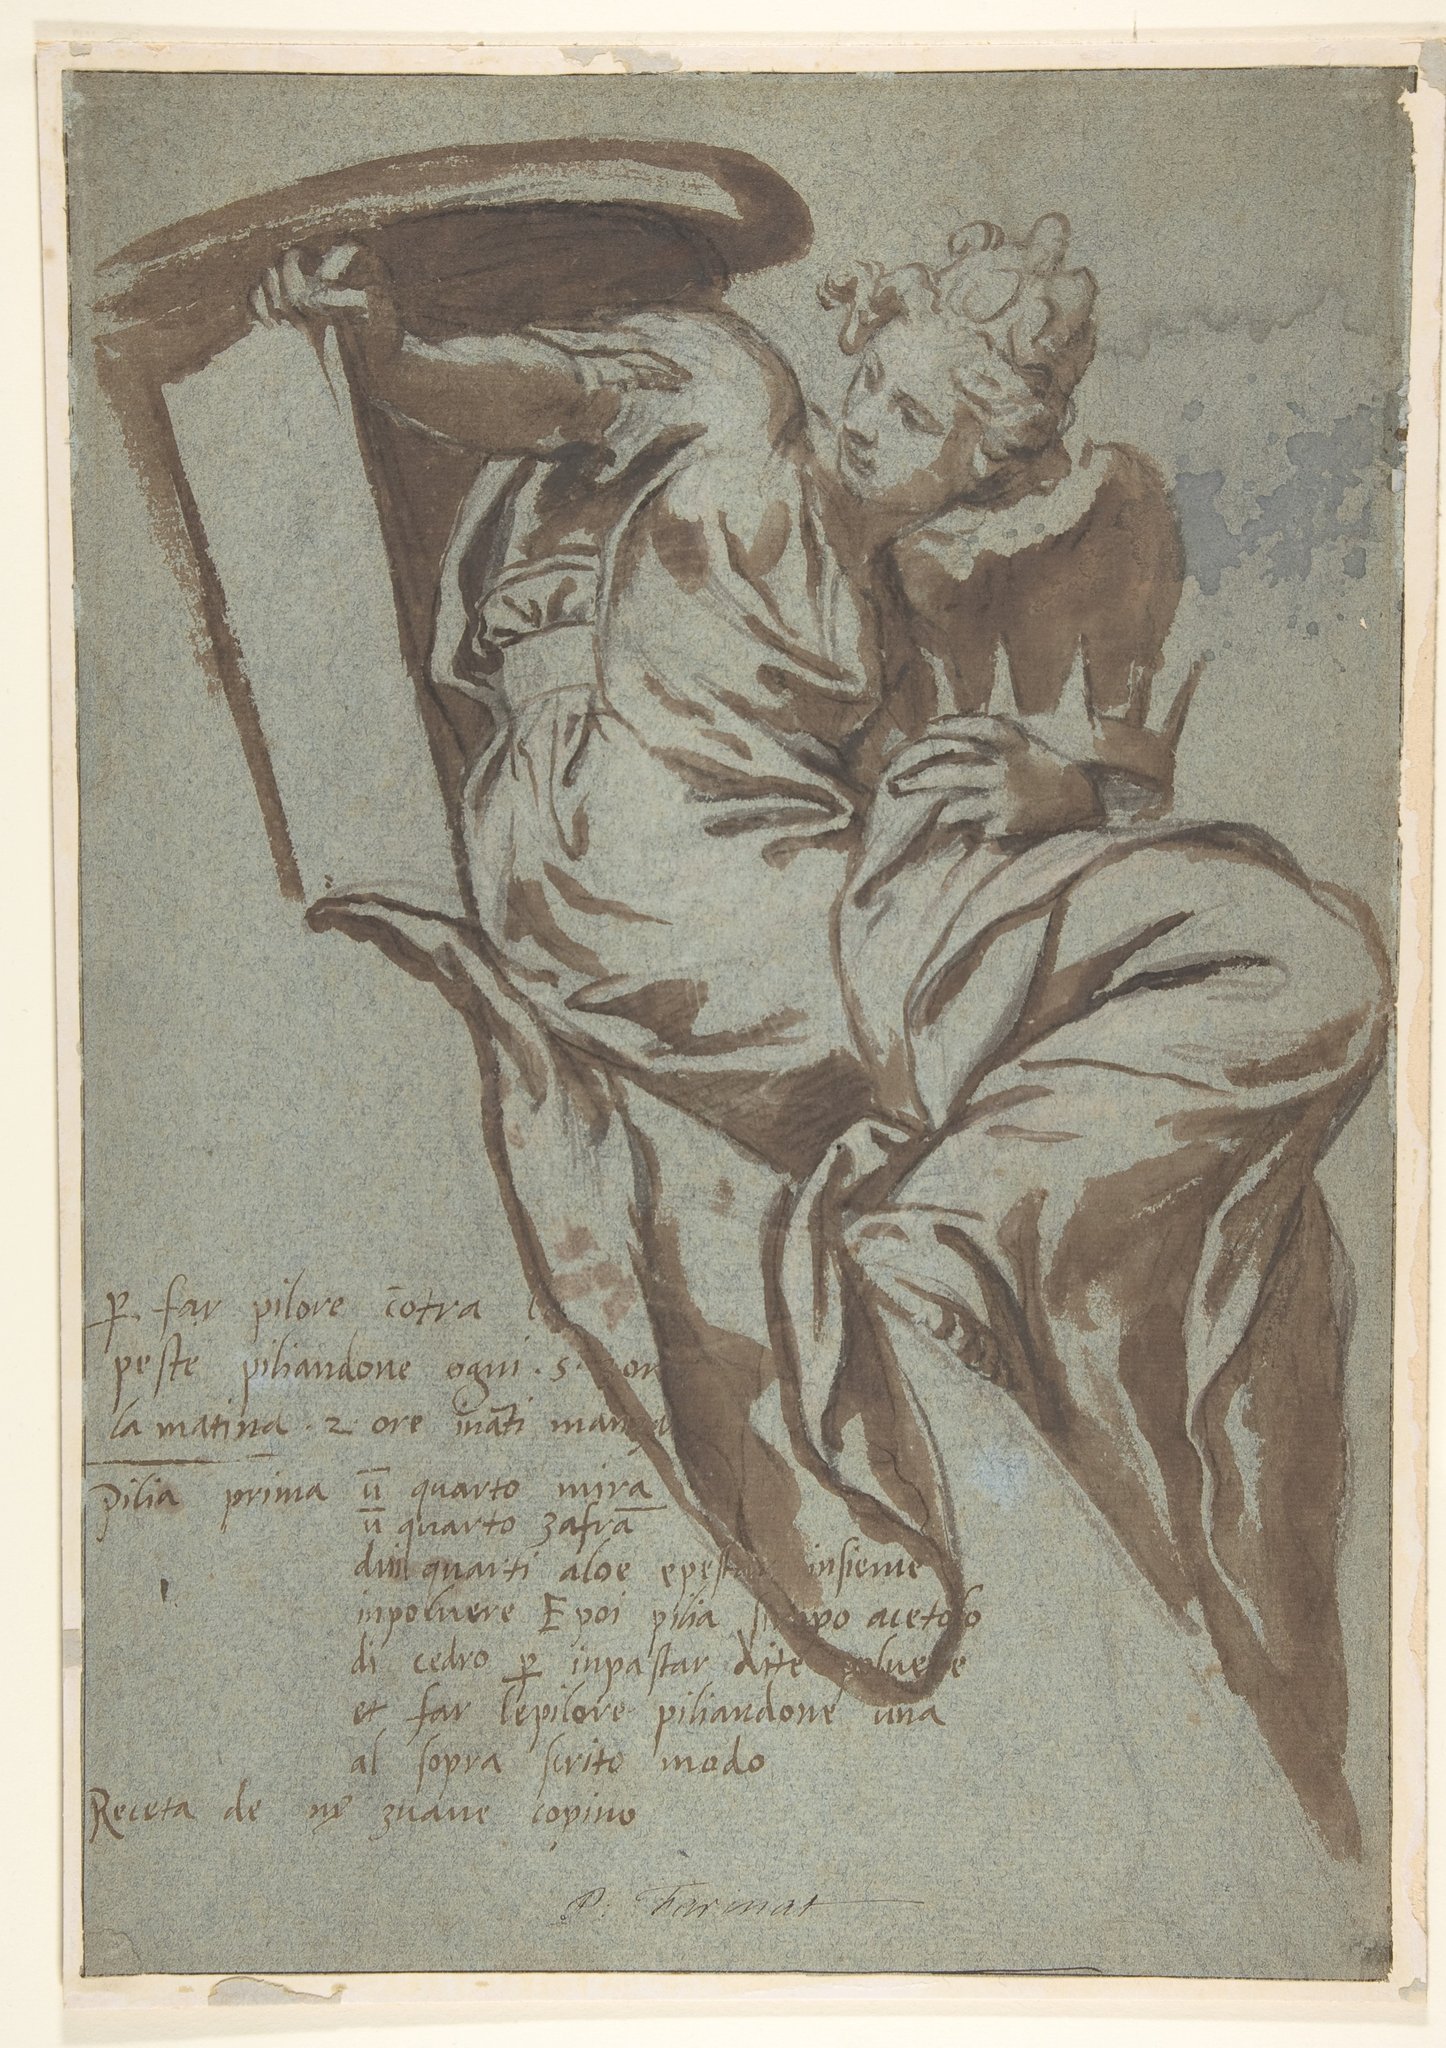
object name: drawing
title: Project for the Decoration of a Spandrel: Winged Female Figure Holding a Tablet and a Crown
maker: paolo farinati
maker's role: artist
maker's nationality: italian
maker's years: 1524-1606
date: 1524-1606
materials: chalk, paper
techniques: brush, wash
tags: women